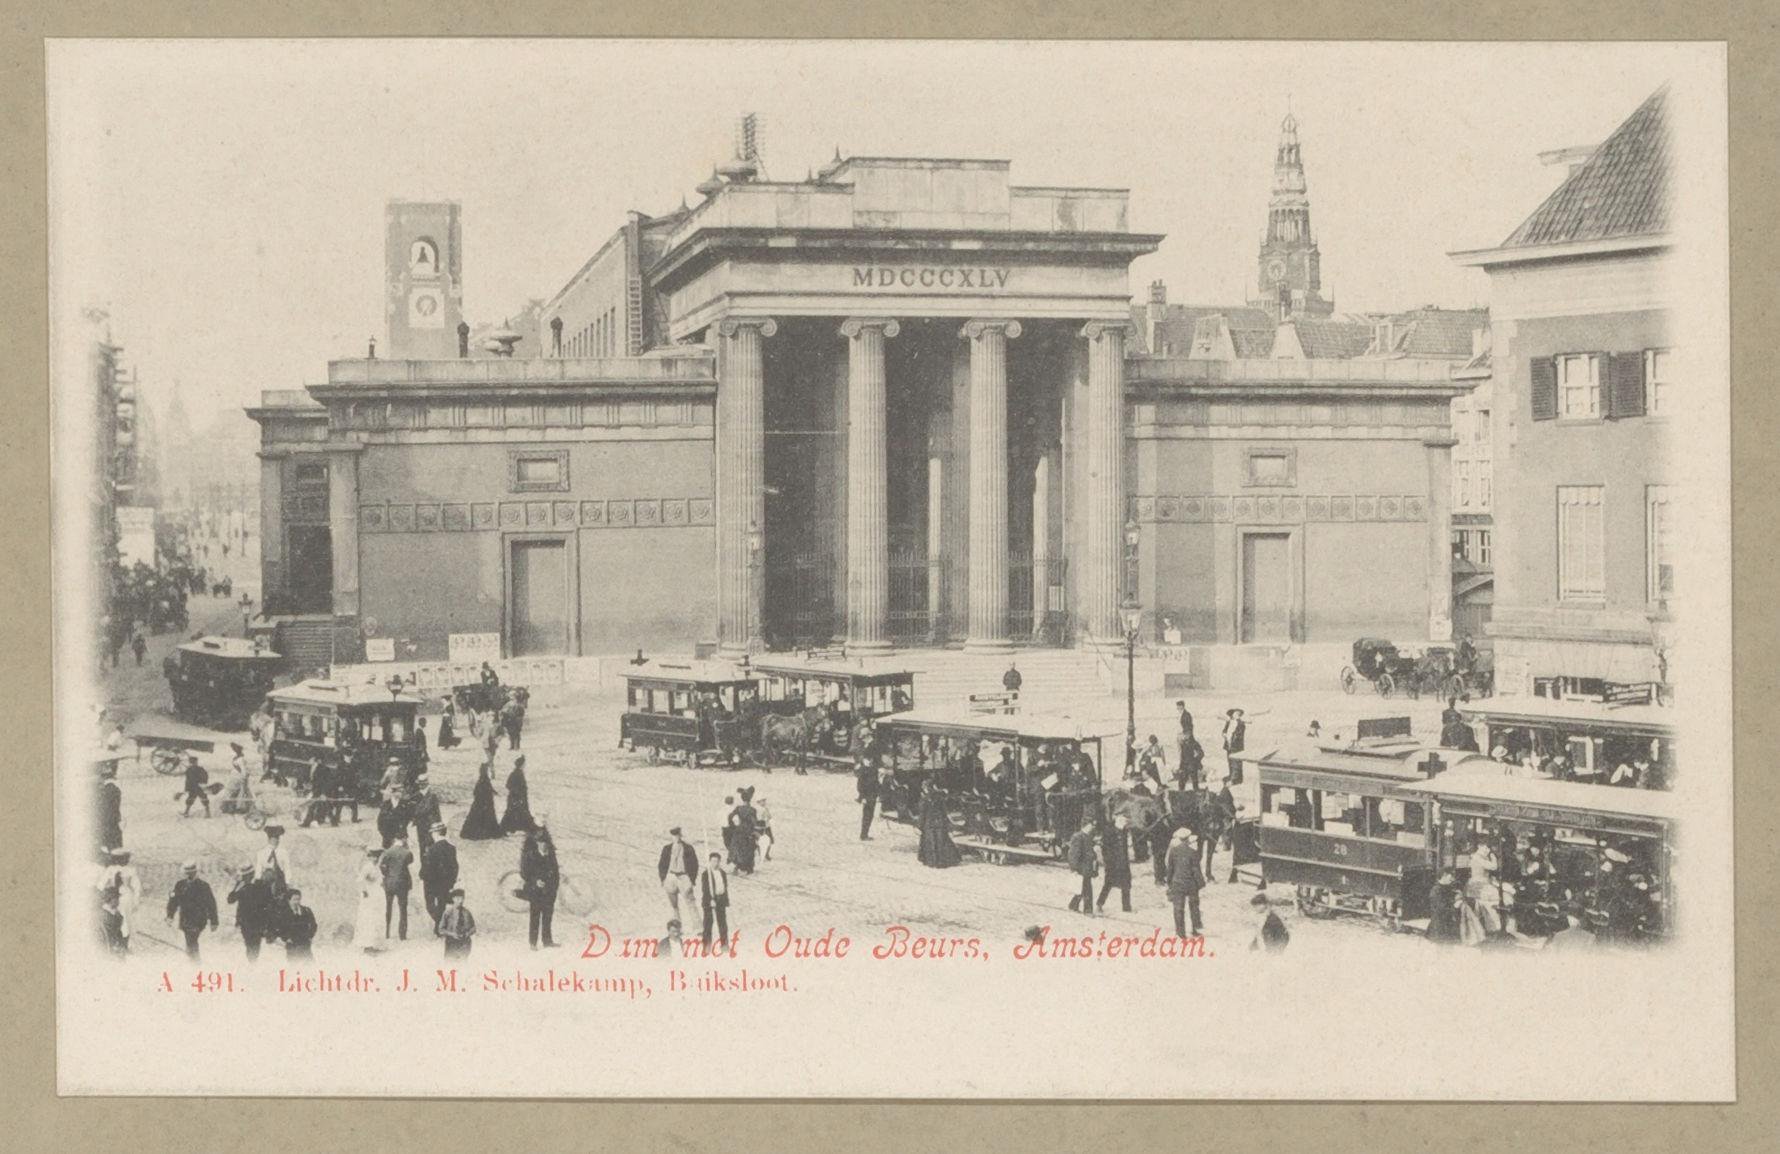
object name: ansichtkaart, prentbriefkaart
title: Gezicht op de Beurs van Zocher te Amsterdam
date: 1903-1905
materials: paper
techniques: photograph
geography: netherlands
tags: diligence, omnibus, horse-tram, stock exchange, stock-market, square, place, circus, etc. (+ city(-scape) with figures, staffage)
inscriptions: collector's mark: Lugt 1641b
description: Onderwerpsrubriek binnen de Atlas Amsterdam: Handel en Zeevaart: Hulpbeurs op de Dam en Beurs (Dam).